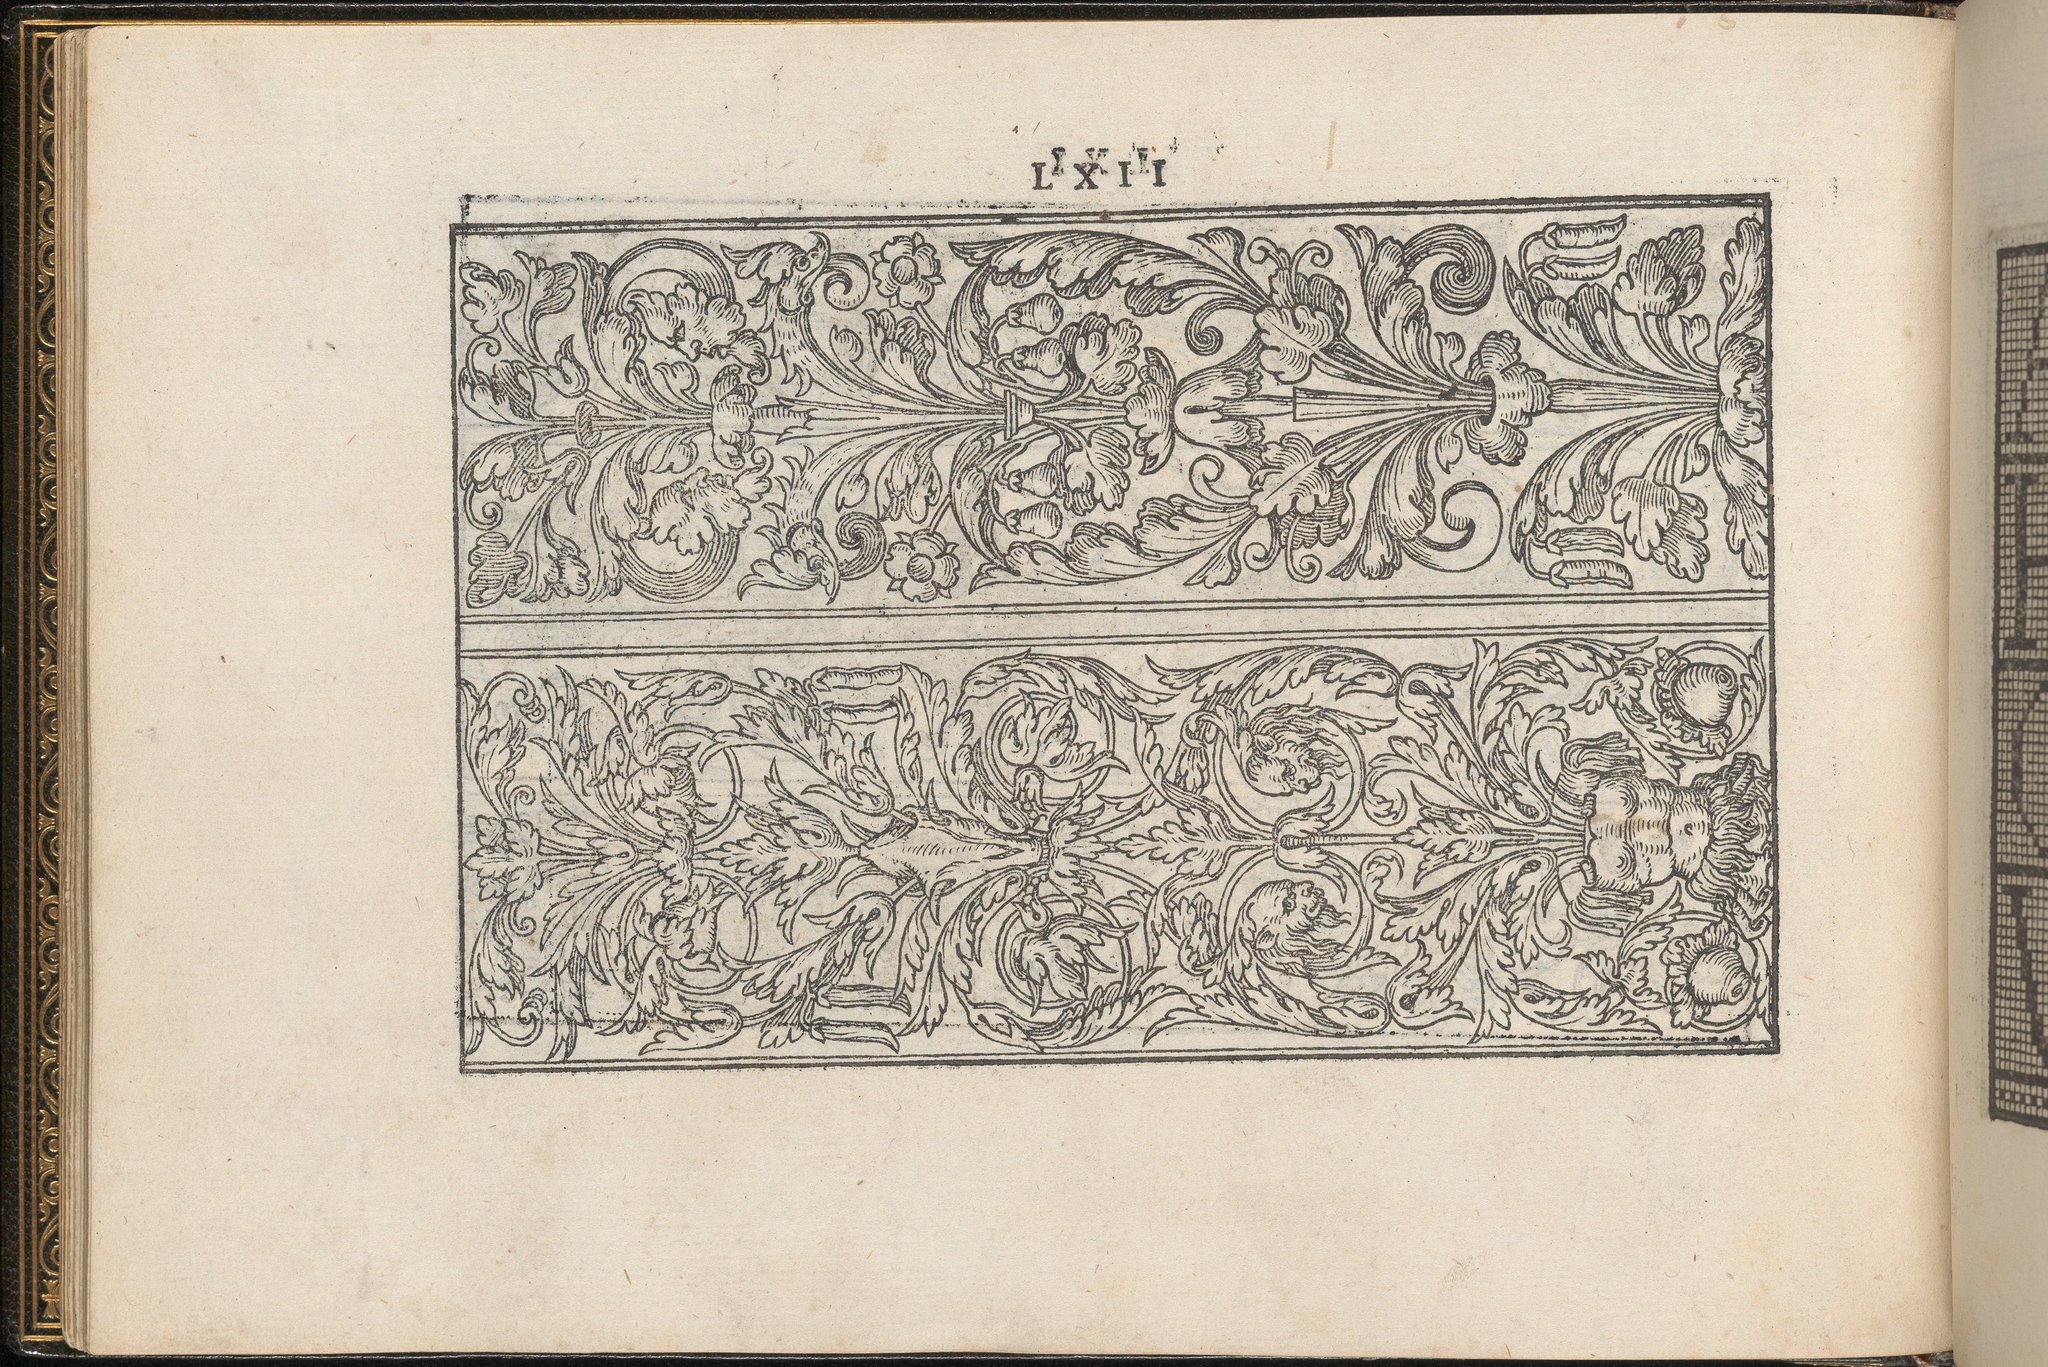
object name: book print ornament architecture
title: La Vera Perfettione del Disegno di varie sorti di recami, page 31 (verso)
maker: giovanni ostaus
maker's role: publisher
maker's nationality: italian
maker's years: 1507-1607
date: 1567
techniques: woodcut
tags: flowers